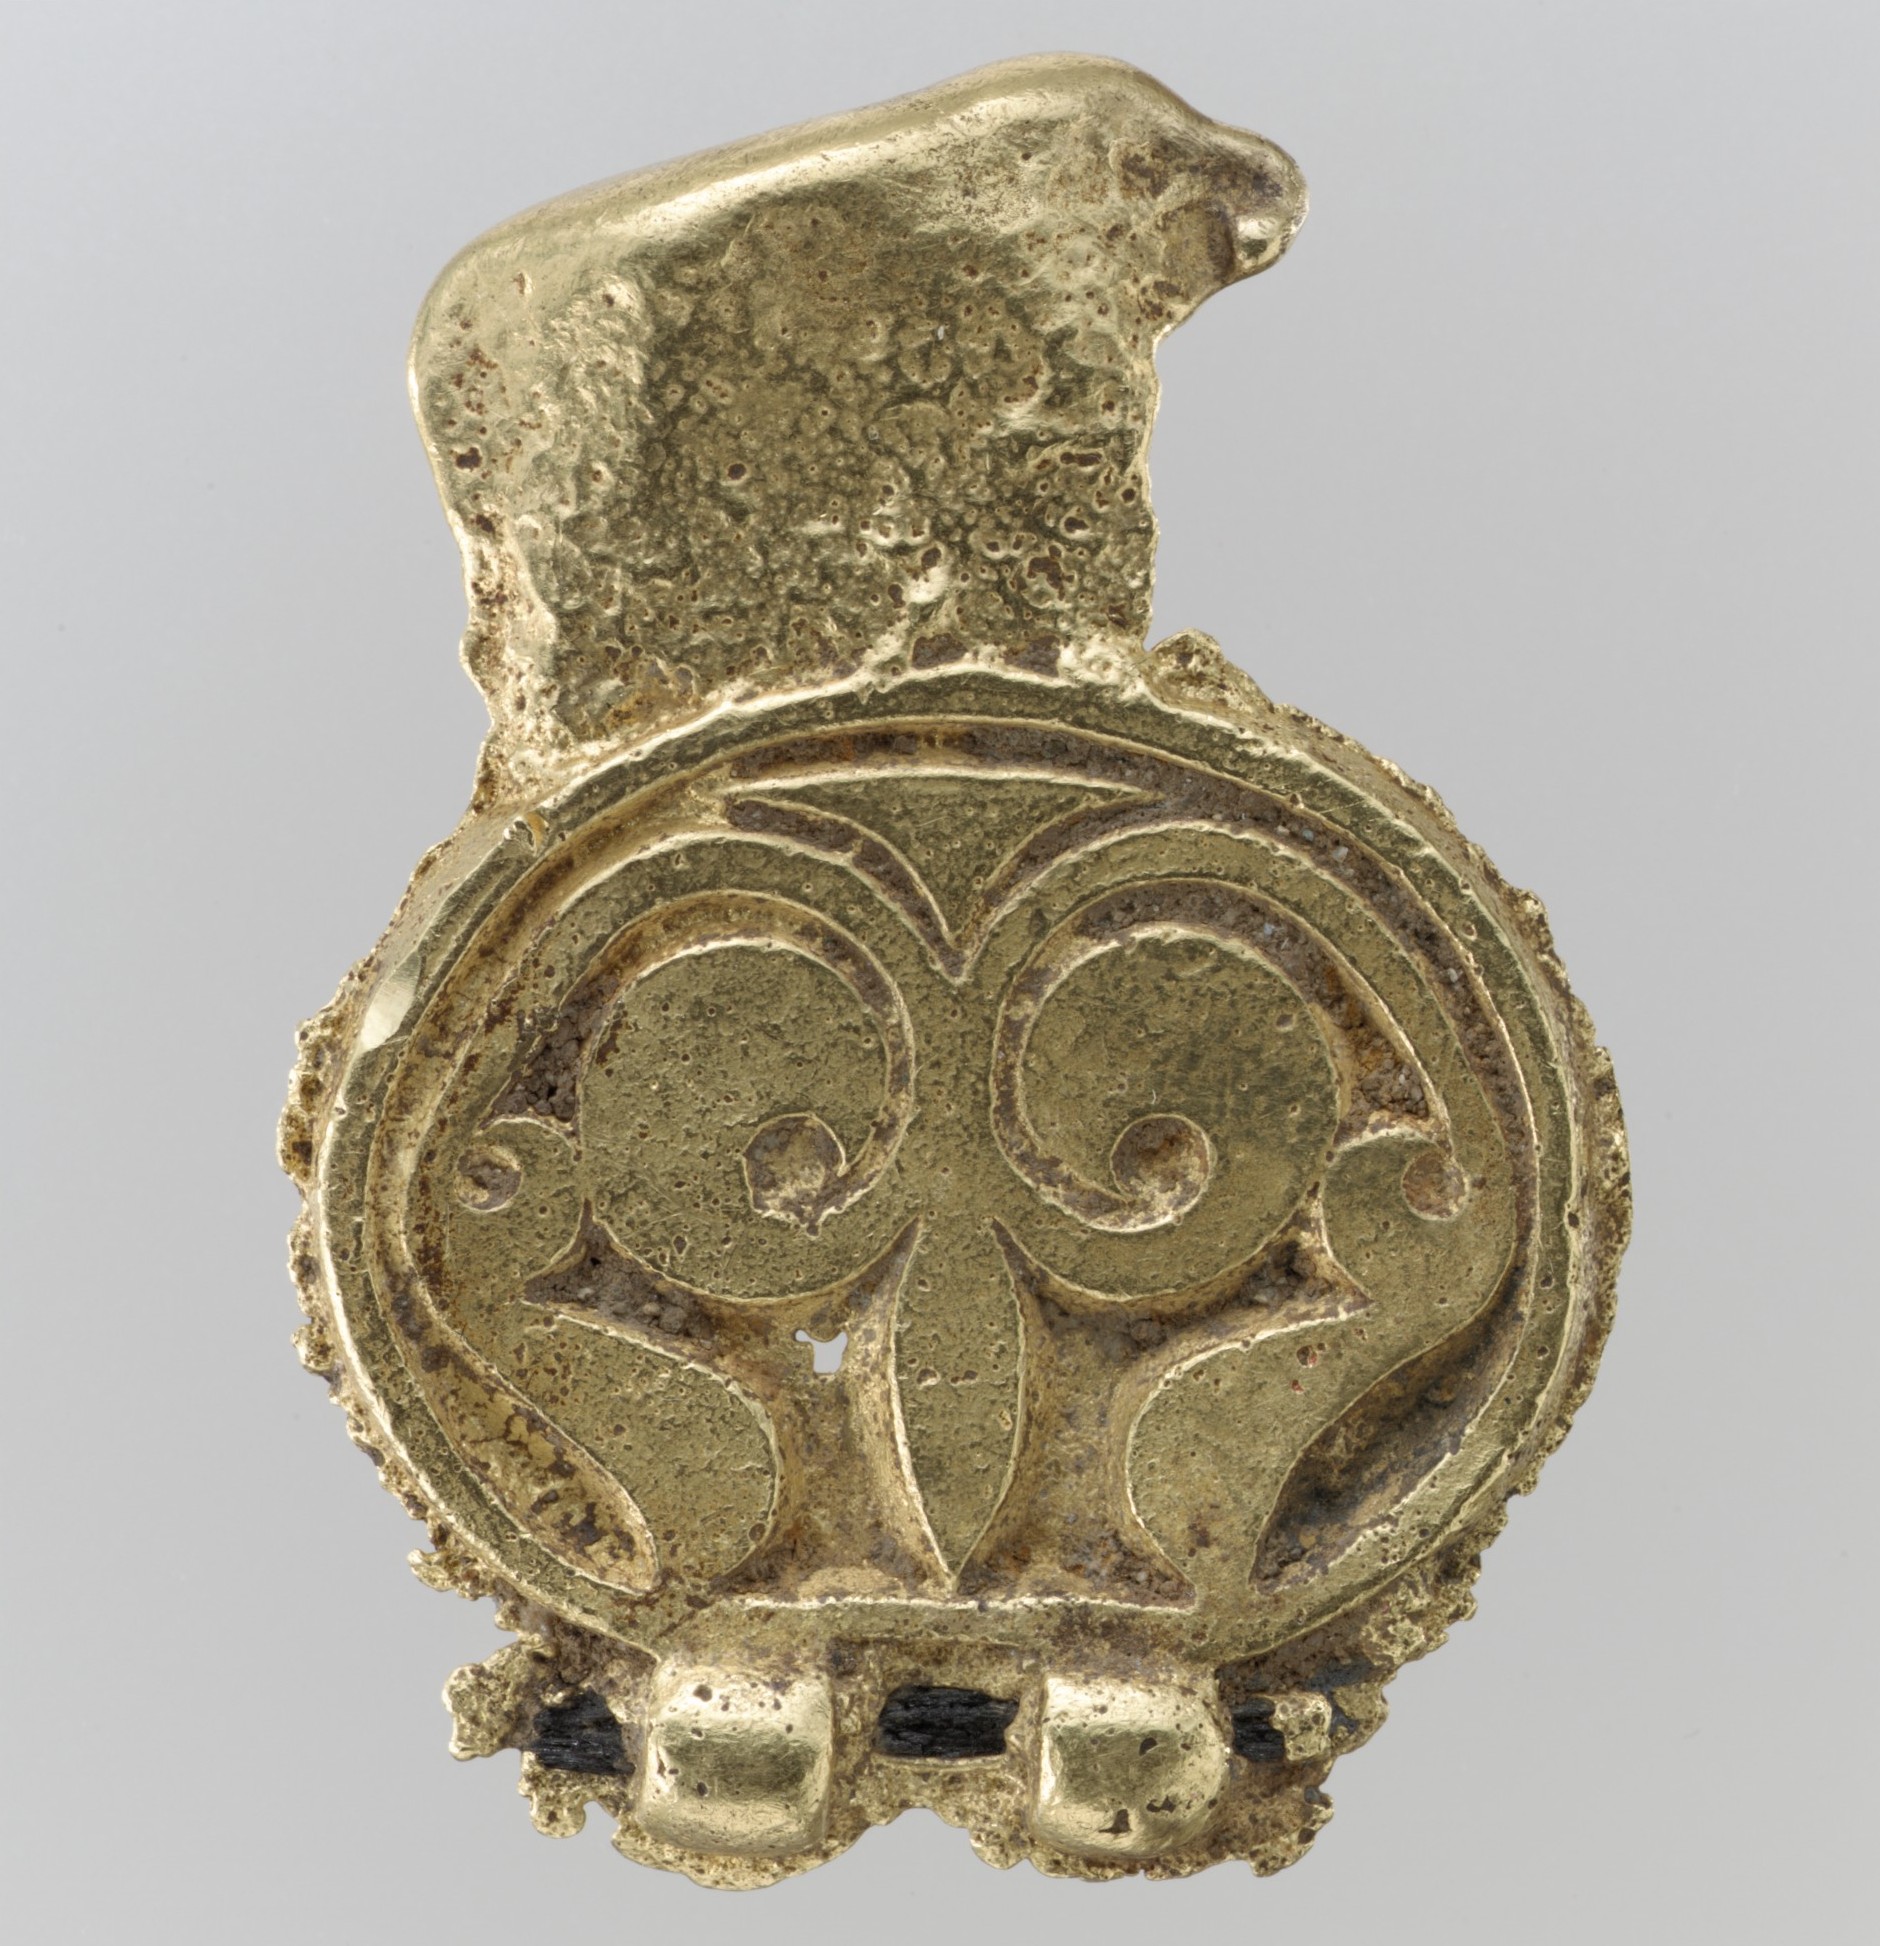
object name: belt mount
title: Gold Belt Mount (Miscast and Unfinished)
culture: avar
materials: gold